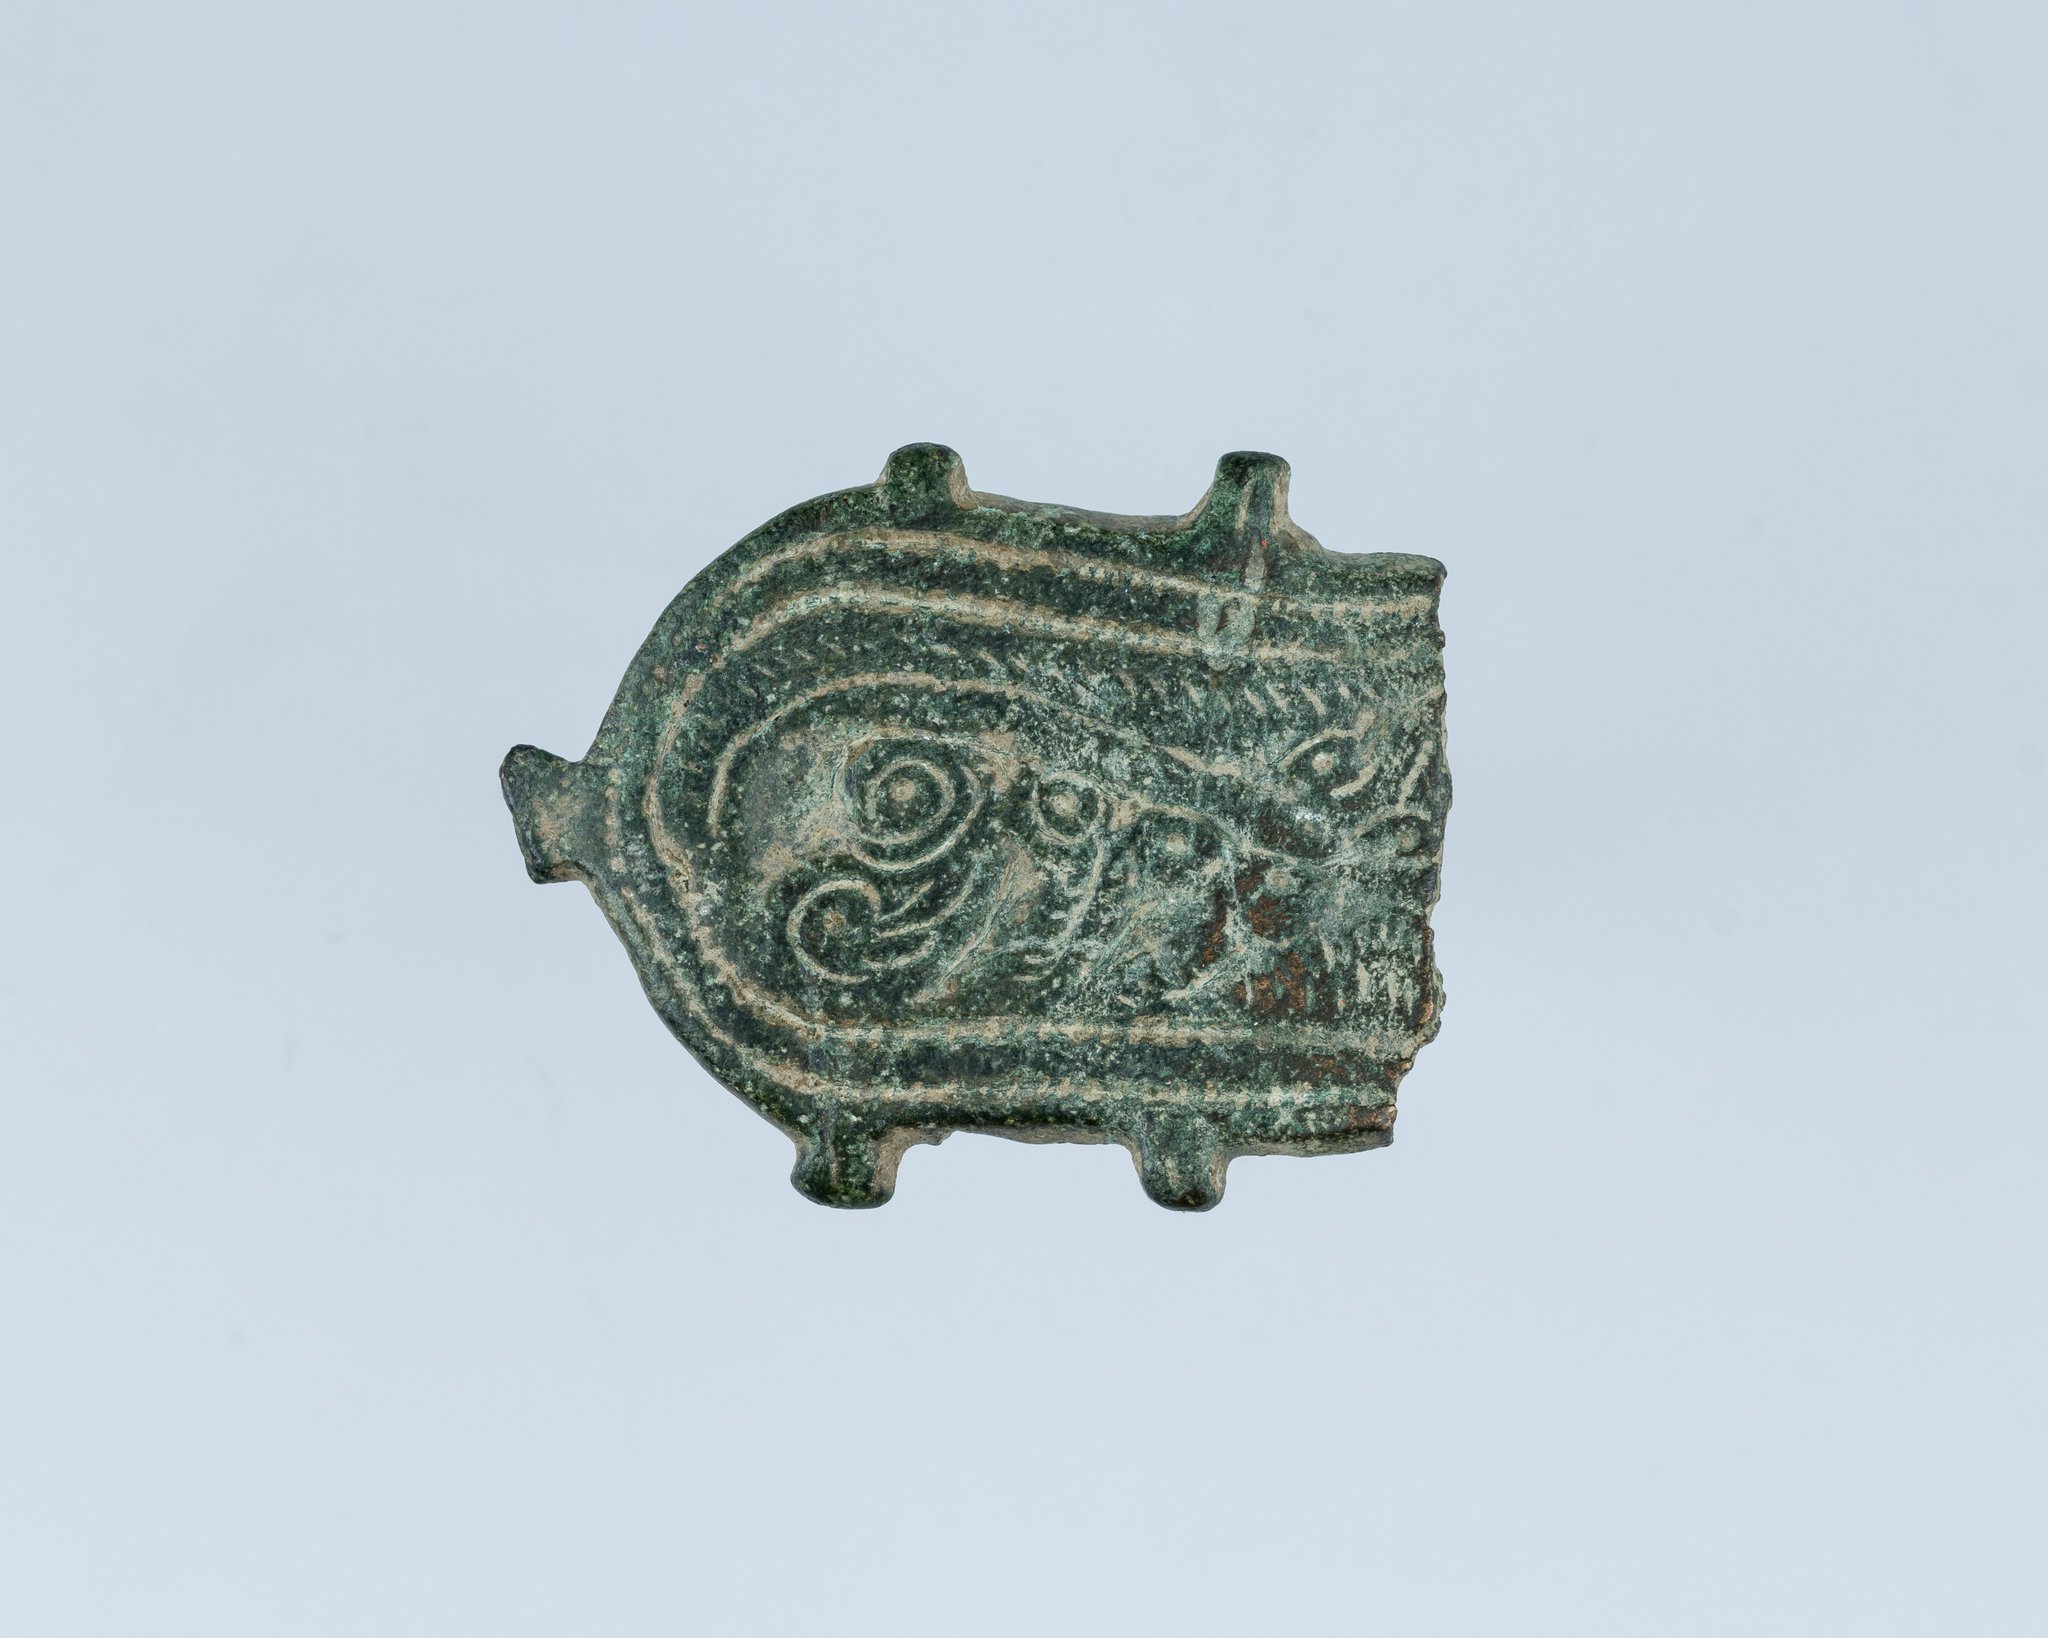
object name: buckle shank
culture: visigothic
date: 401-700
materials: bronze